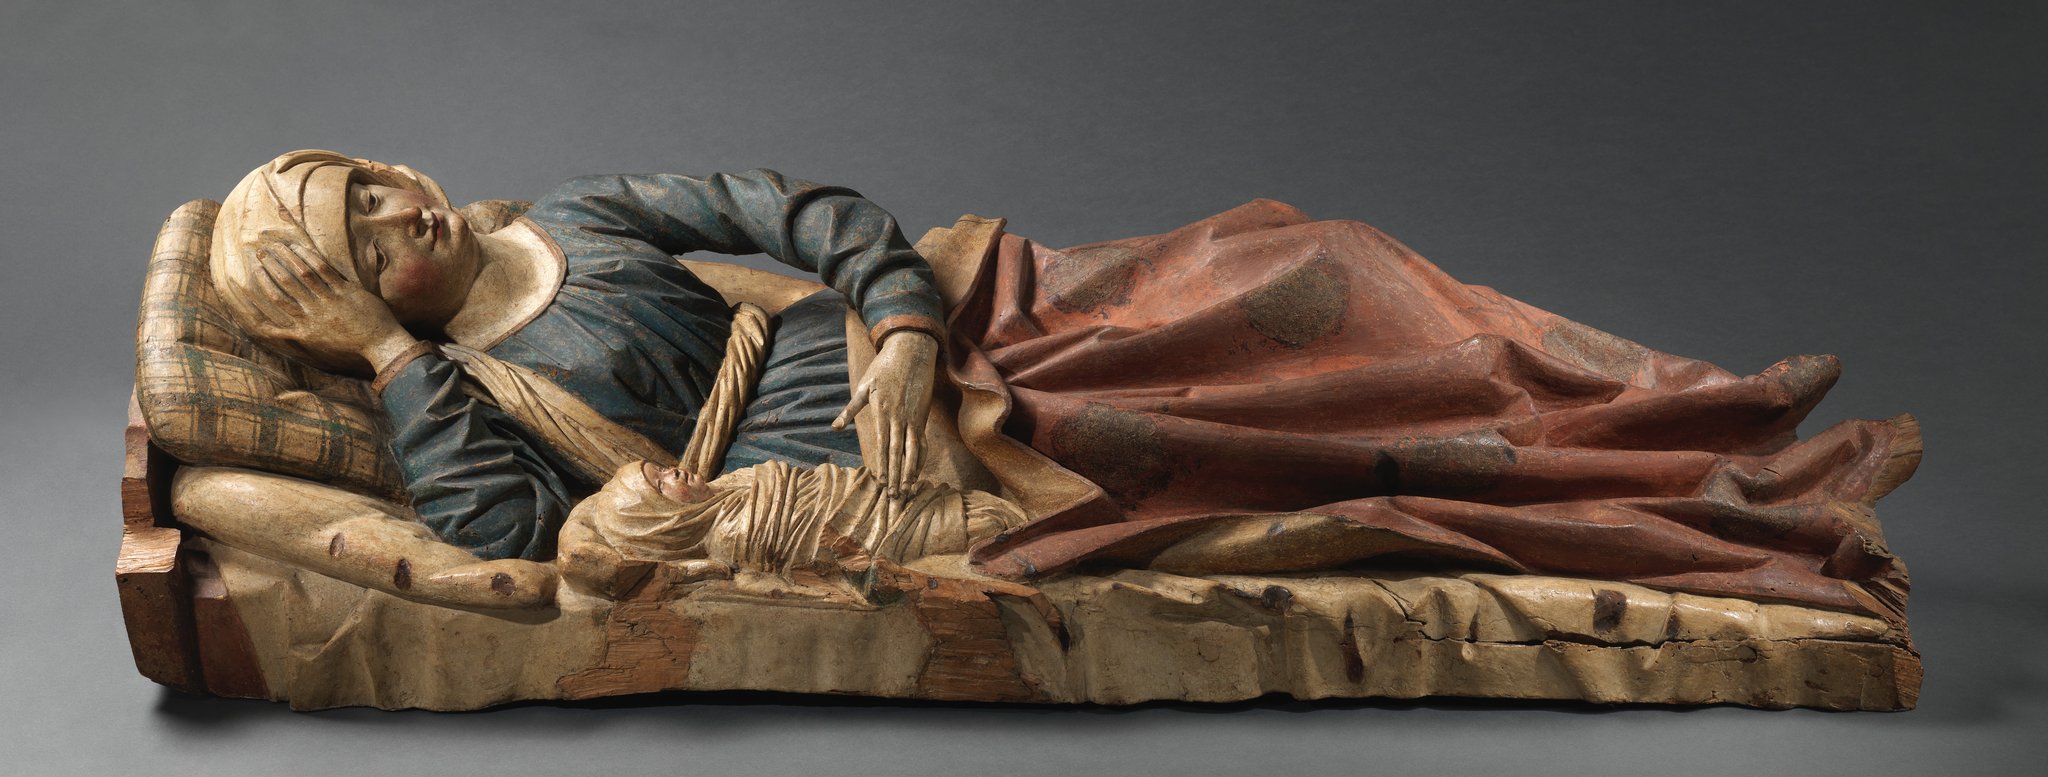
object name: statue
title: Nativity of the Virgin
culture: german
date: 1480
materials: paint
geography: germany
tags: infants,saint anne,virgin mary